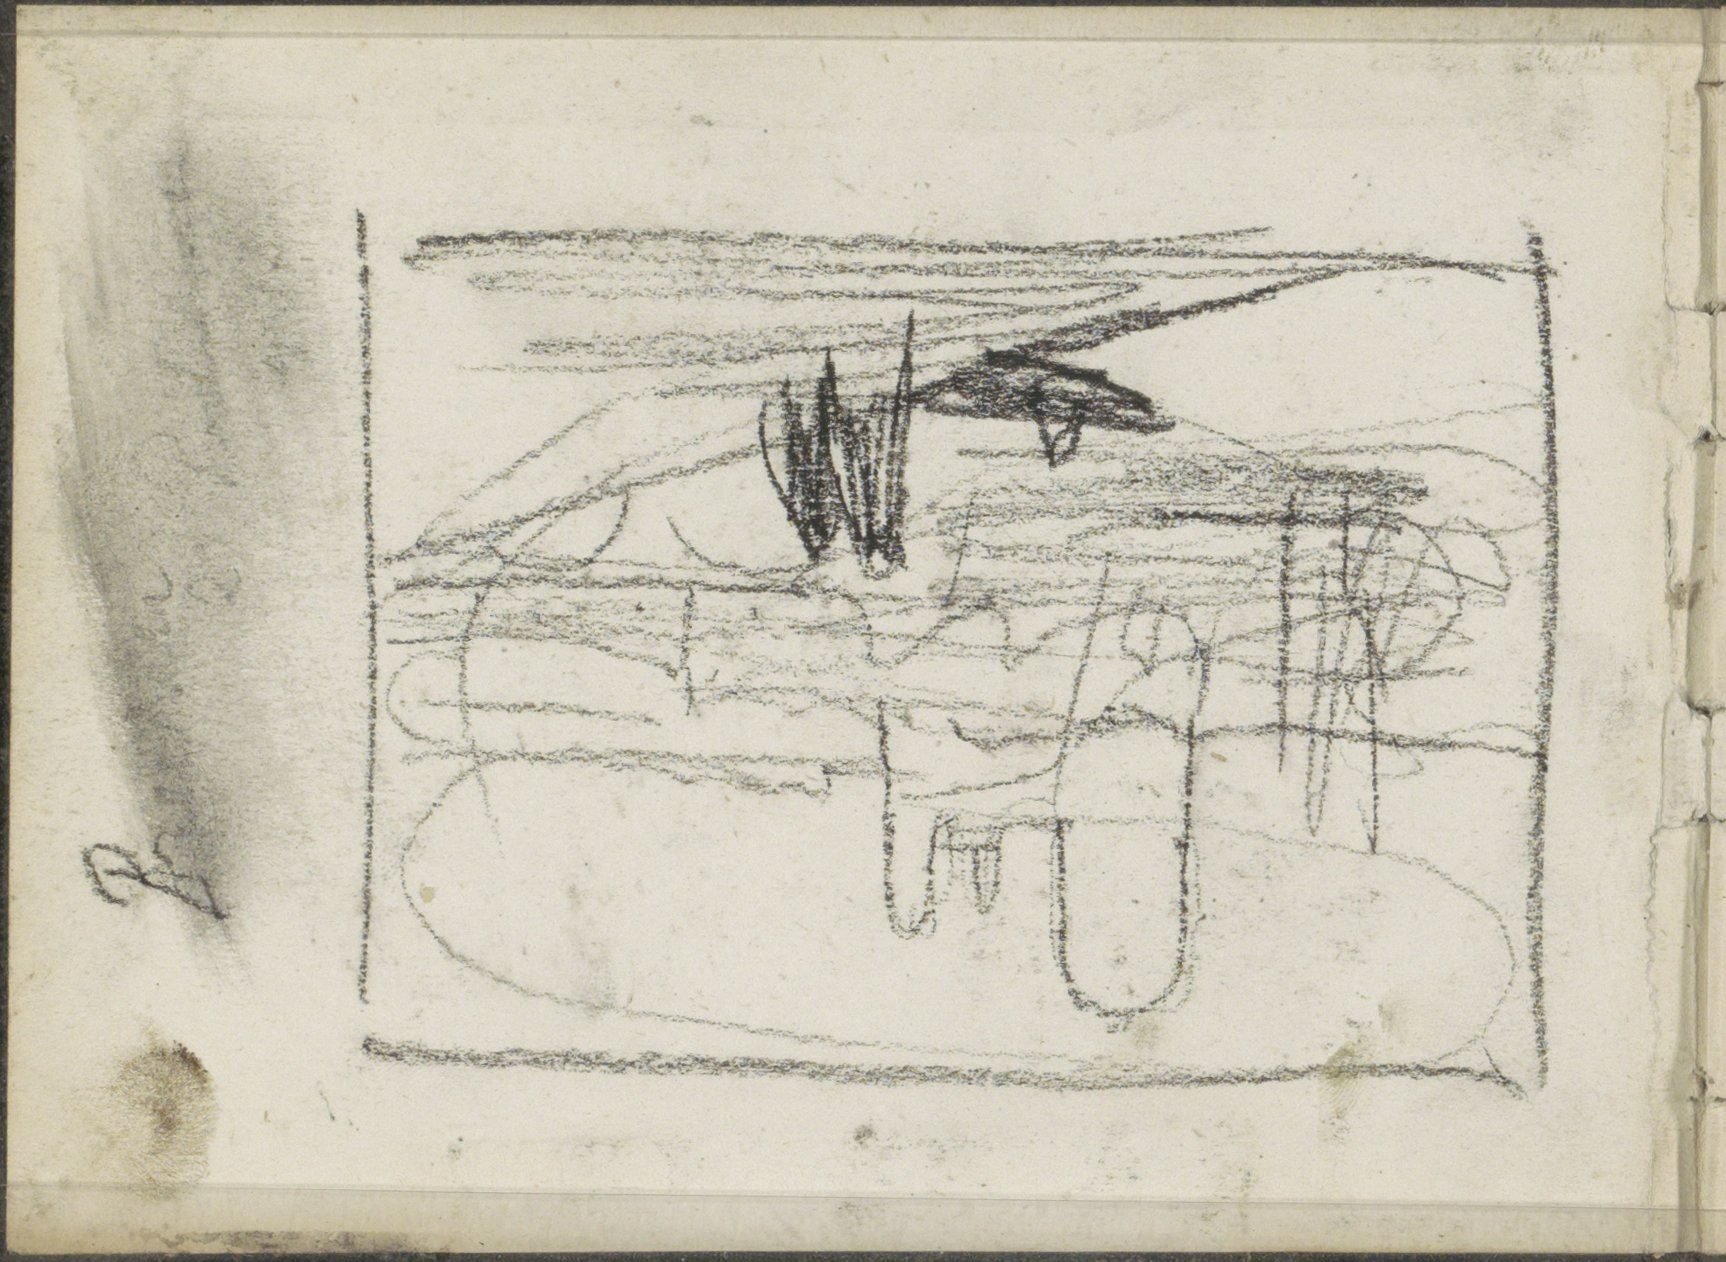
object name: endleaf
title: Figuren op een kade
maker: marius bauer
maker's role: draughtsman, print maker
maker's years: 1867-1932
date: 1877-1932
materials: chalk, paper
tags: anatomy (non-medical), river, church (exterior), quay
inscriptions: annotation: ‘Brei[...]/ za P[...]’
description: Op de achtergrond is het silhouet van een kerk te zien. Voorste schutblad uit een schetsboek met 32 bladen.